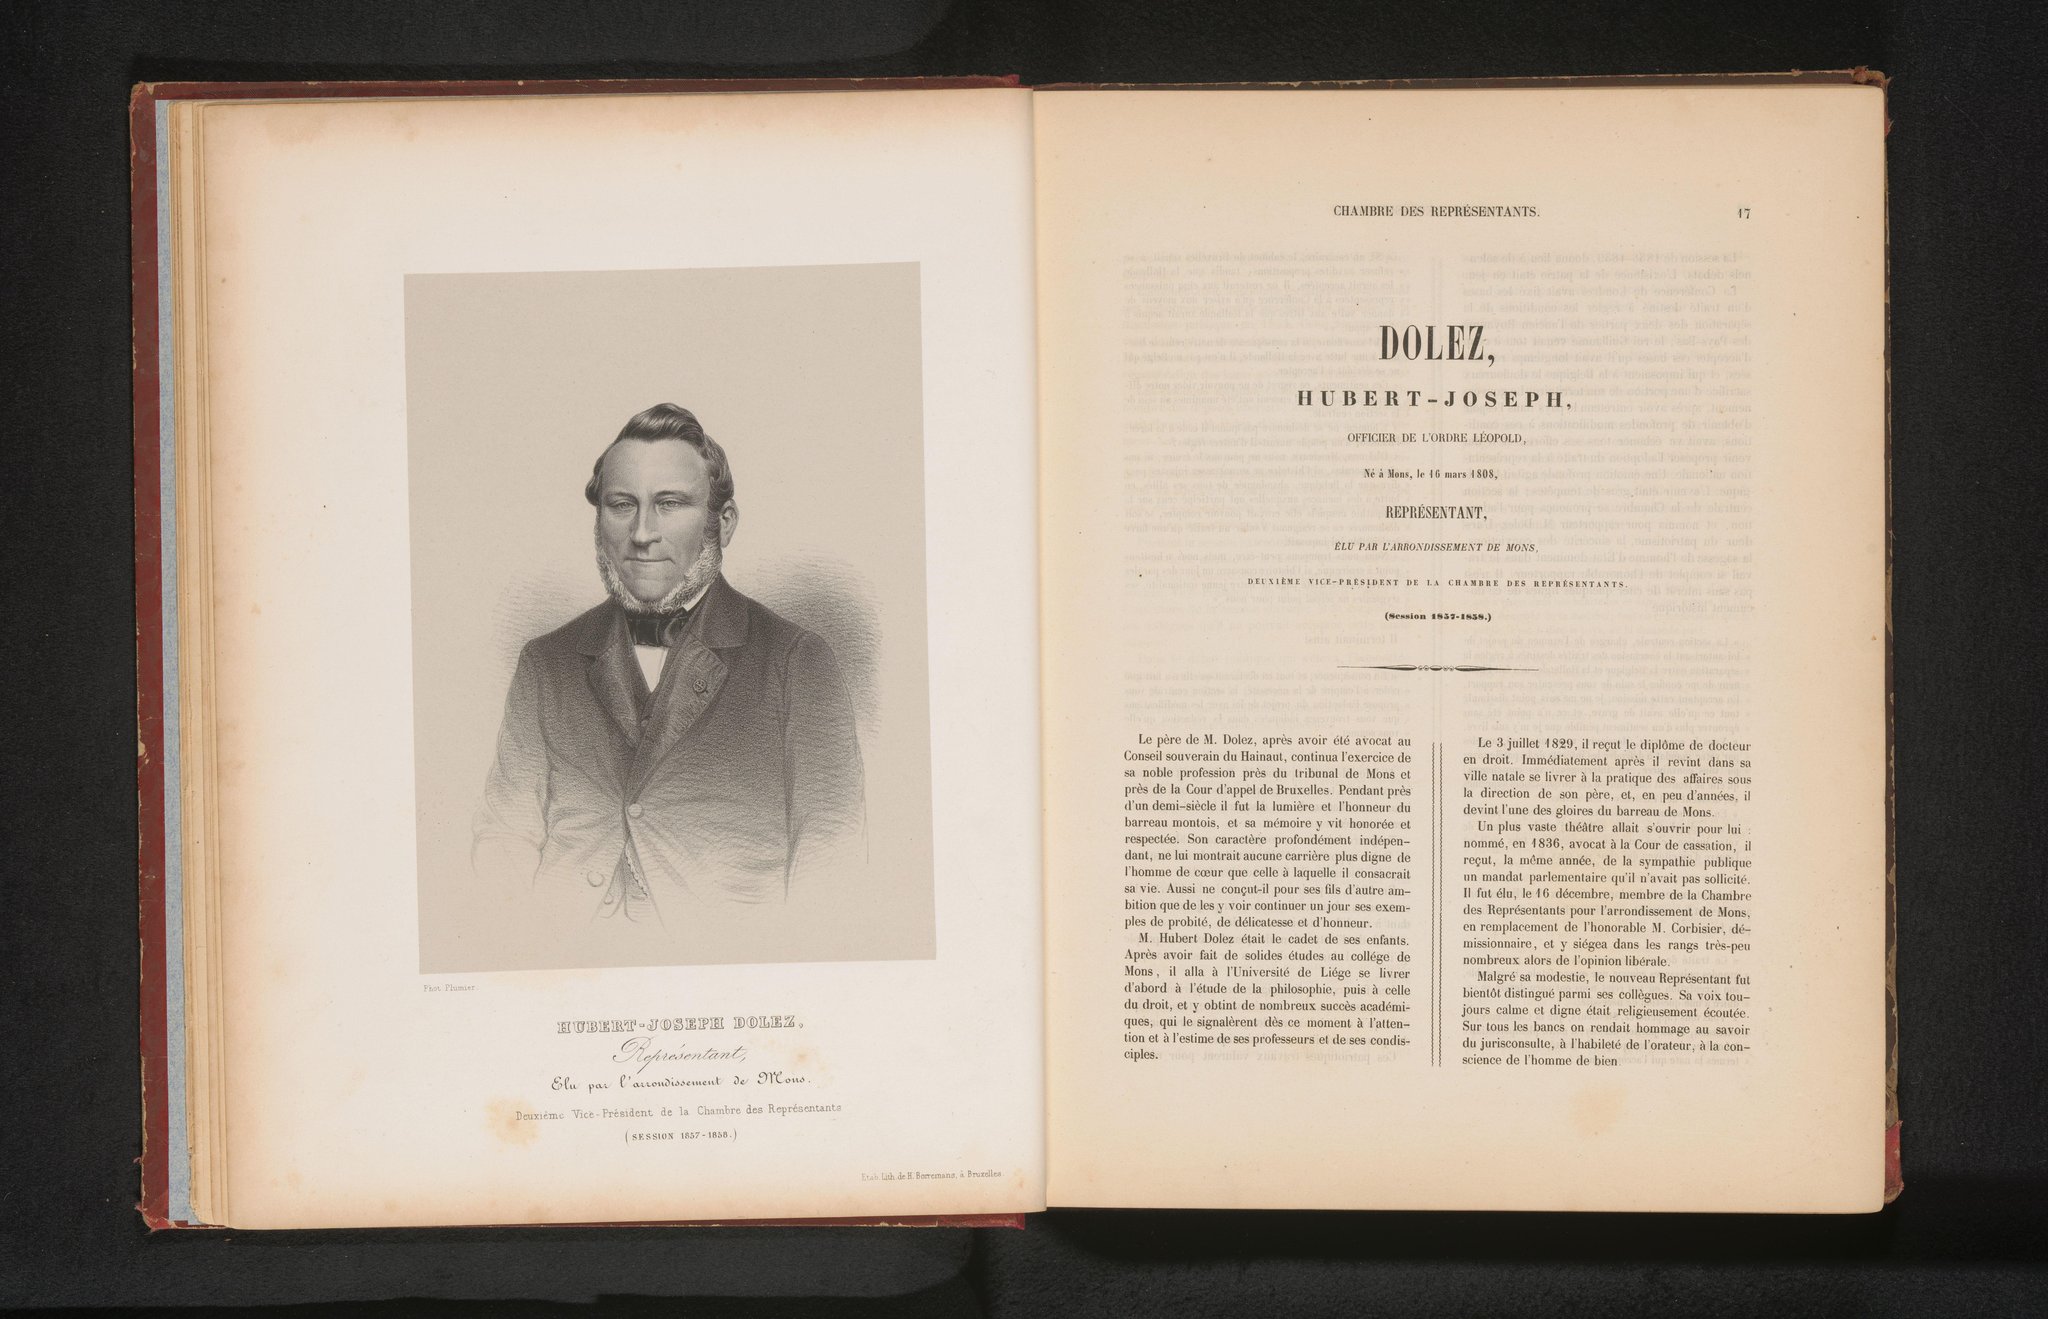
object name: print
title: Reproductie van een foto van een portret van Hubert-Joseph Dolez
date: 1853-1858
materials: paper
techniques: lithograph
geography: brussels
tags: brussels, politician, historical persons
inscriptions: inscription: ‘Représentant,/ Elu par l'arrondissement de Mons./ Deuxième Vice-Président de la Chambre des Représentants./ (session 1857-1858.)’